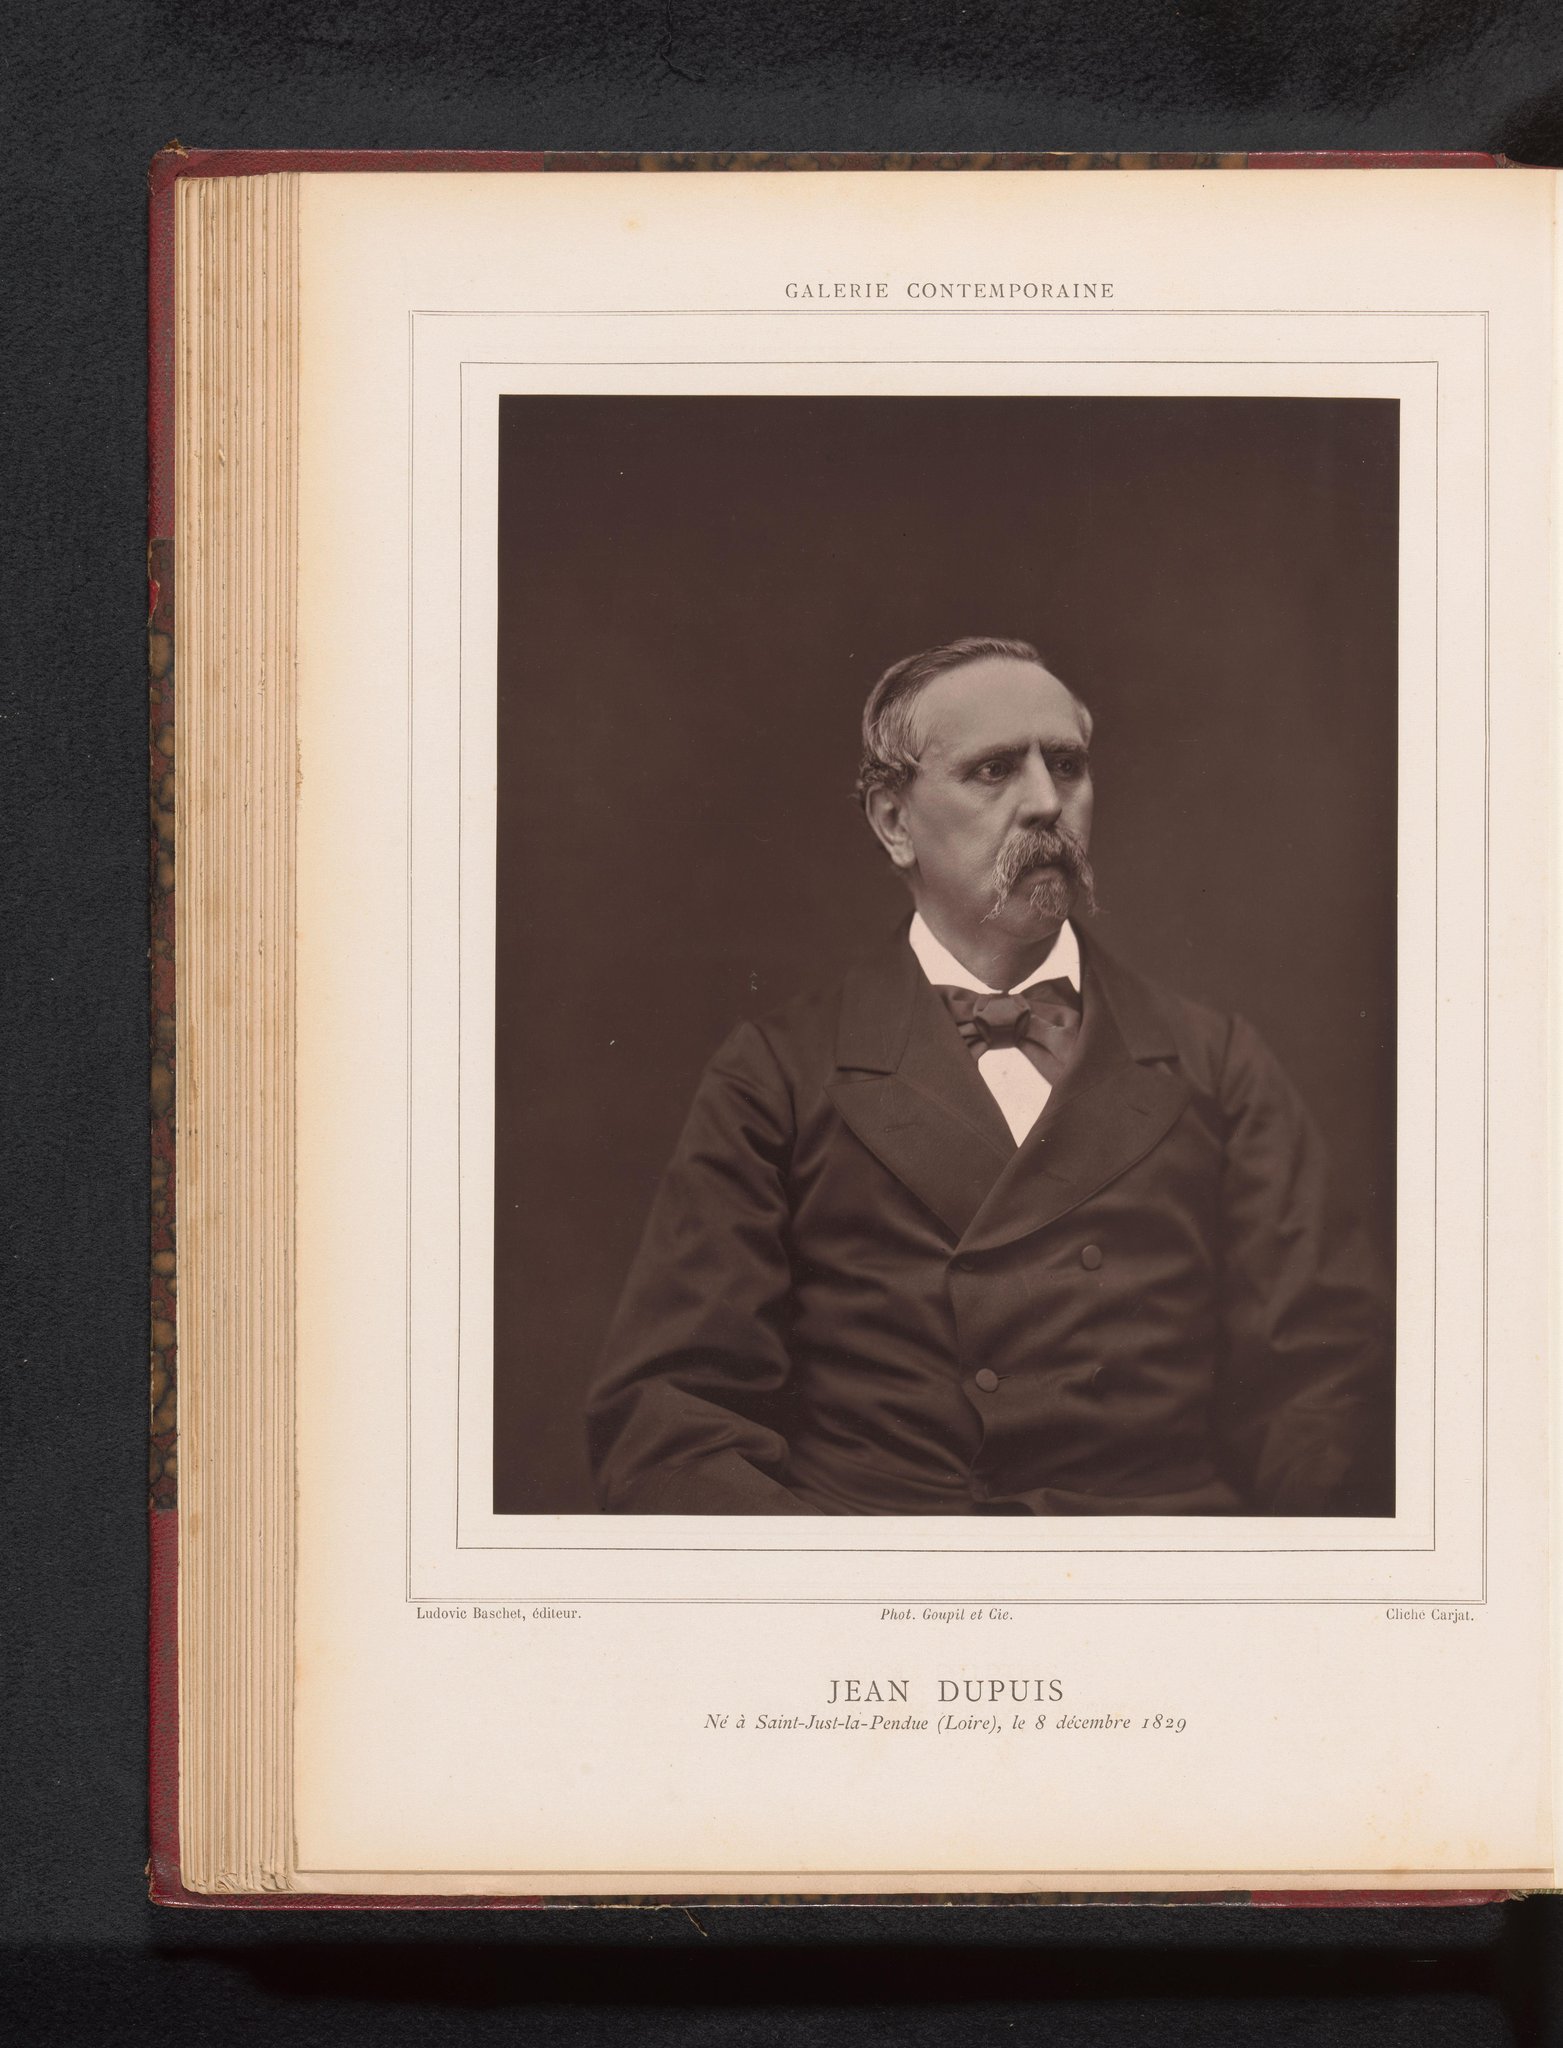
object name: photomechanical print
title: Jean Dupuis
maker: étienne carjat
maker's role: draughtsman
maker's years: 1828-1906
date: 1867-1880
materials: paper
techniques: woodburytype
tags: adult man, historical persons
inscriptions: inscription: ‘Galerie Contemporaine/ Ludovic Baschet, éditeur./ Né a Saint-Just-la-Pendue (Loire), le 8 décembre 1829’